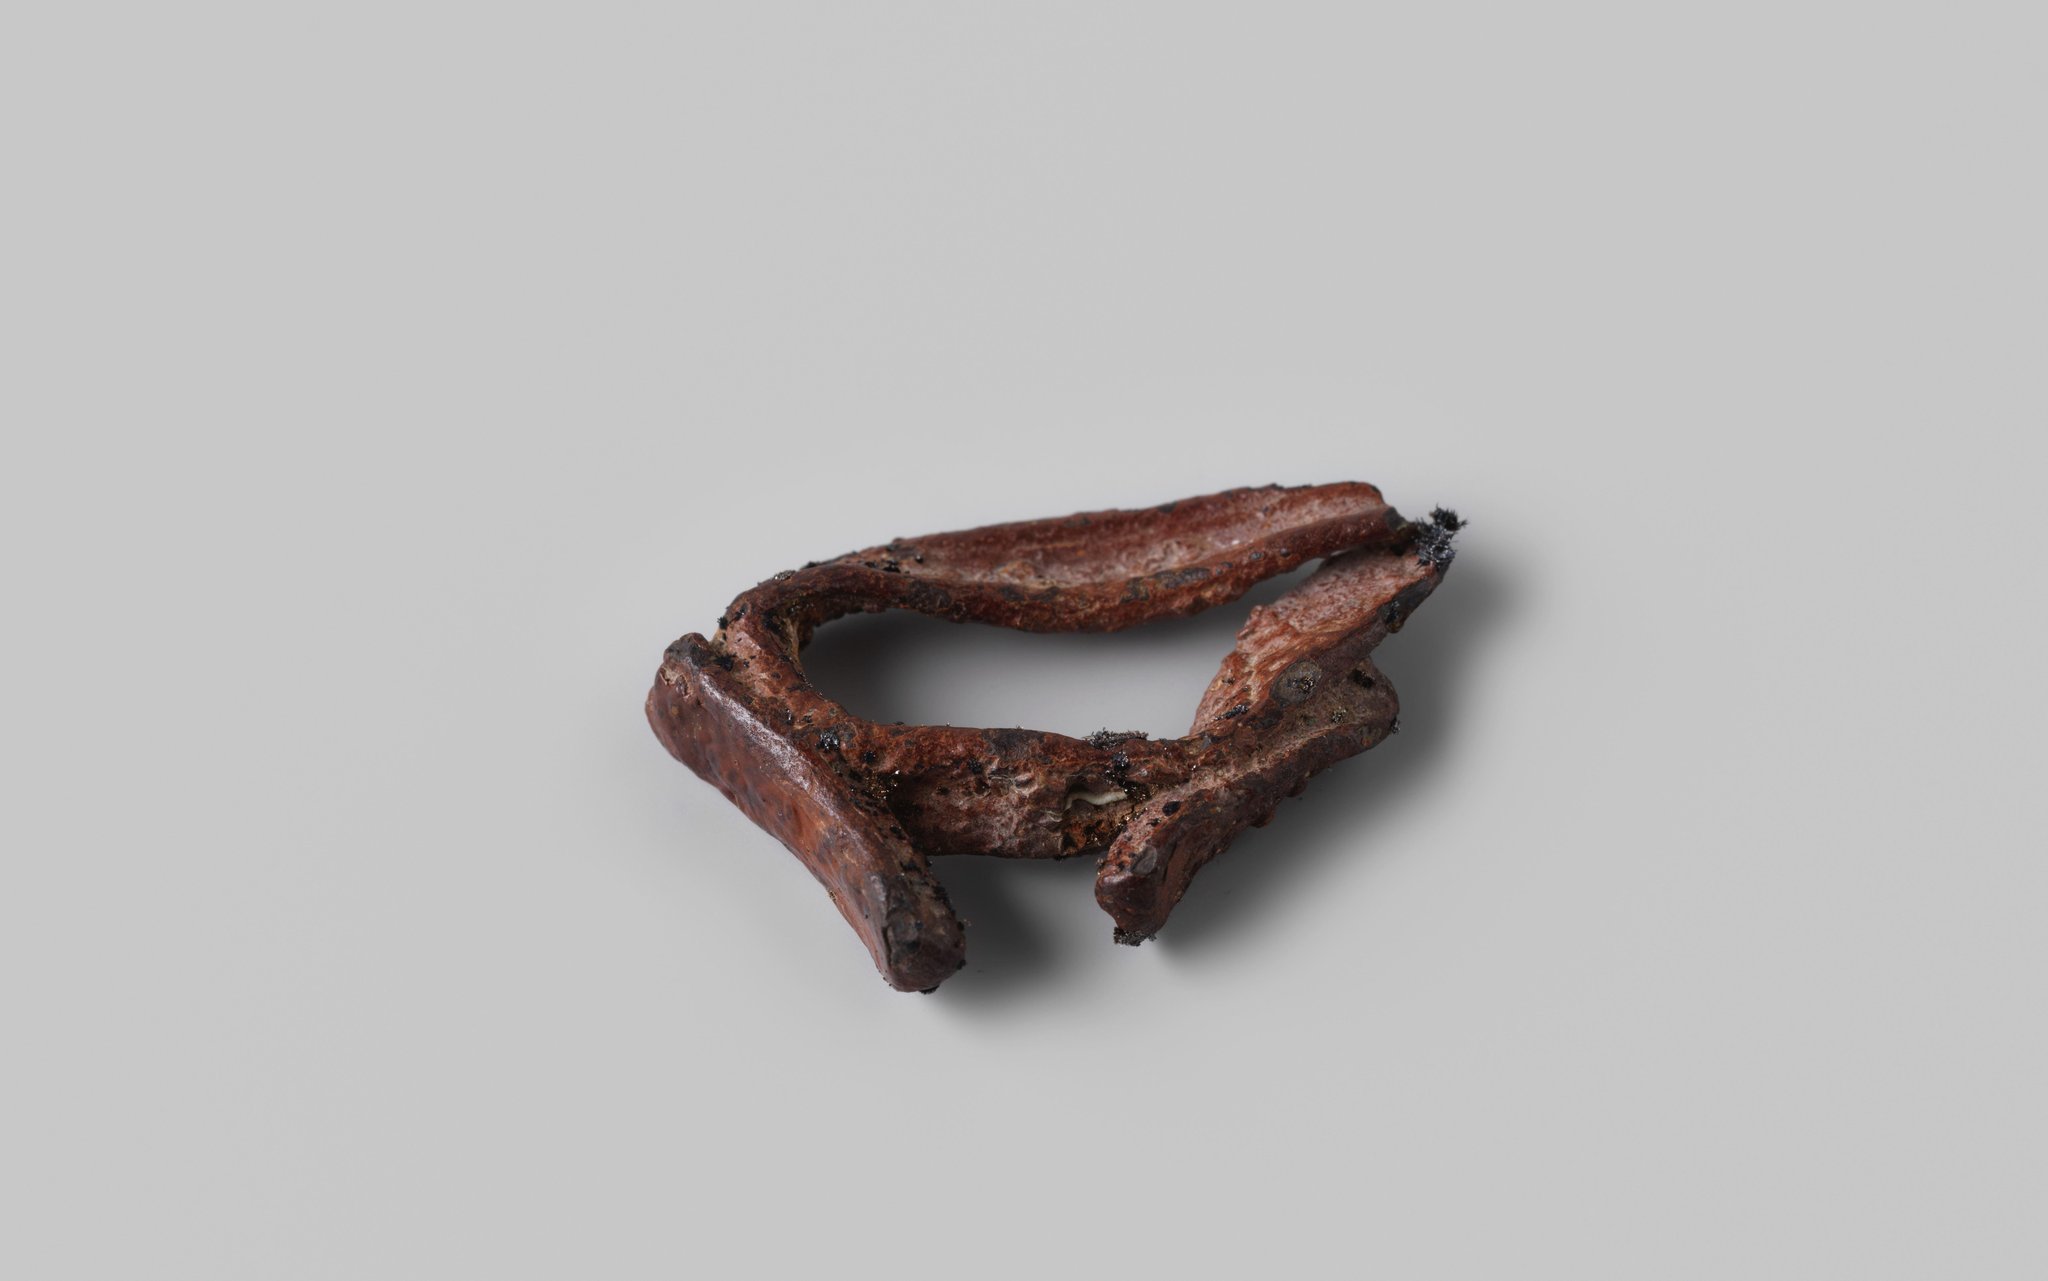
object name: fragment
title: Fragment van koper uit het wrak van de Oost-Indiëvaarder Hollandia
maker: Anonymous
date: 1700-1743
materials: copper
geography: netherlands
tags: verenigde oostindische compagnie, hollandia (schip), annet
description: Varied parts or fragments, strips and strip-shaped fragments; fragm.